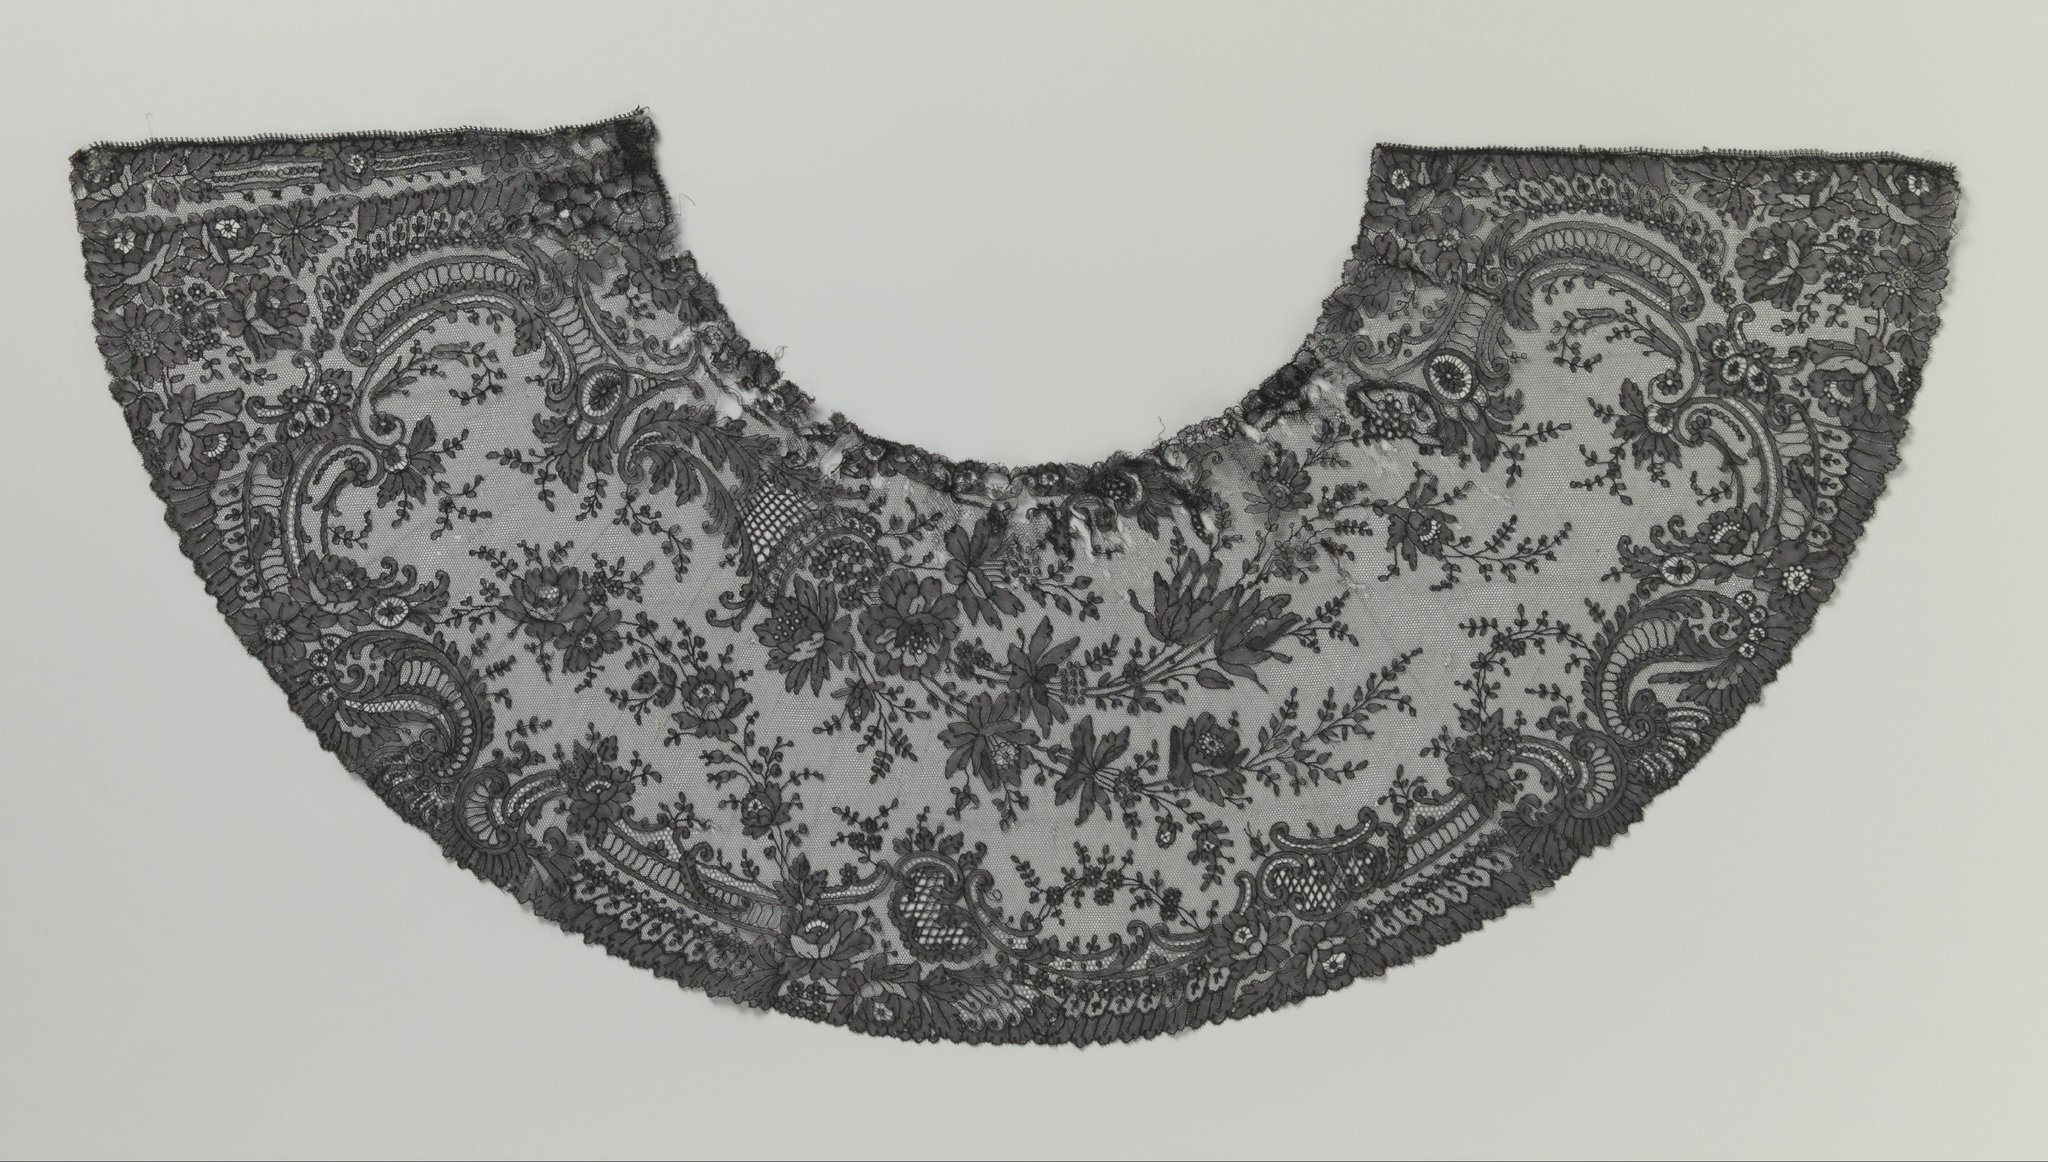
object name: waaierblad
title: Waaierblad van zwarte kloskant met hoorn van overvloed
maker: Anonymous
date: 1850-1860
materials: silk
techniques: lace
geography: france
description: Waaierblad van zwarte kloskant: Chantilly-kant. Op een lege traliegrond staat een asymmetrisch dessin. De buitenrand vertoont c-voluten en rocailles, gevuld met palissaden en rasterwerk. Op de rechterzijde bij het versierde rechter buitenbeen en beginnend met een voluut, ligt een hoorn van overvloed met een groot uitkomend boeket met anemoon(?), tulpen, narcis, lelietjes enzovoort.